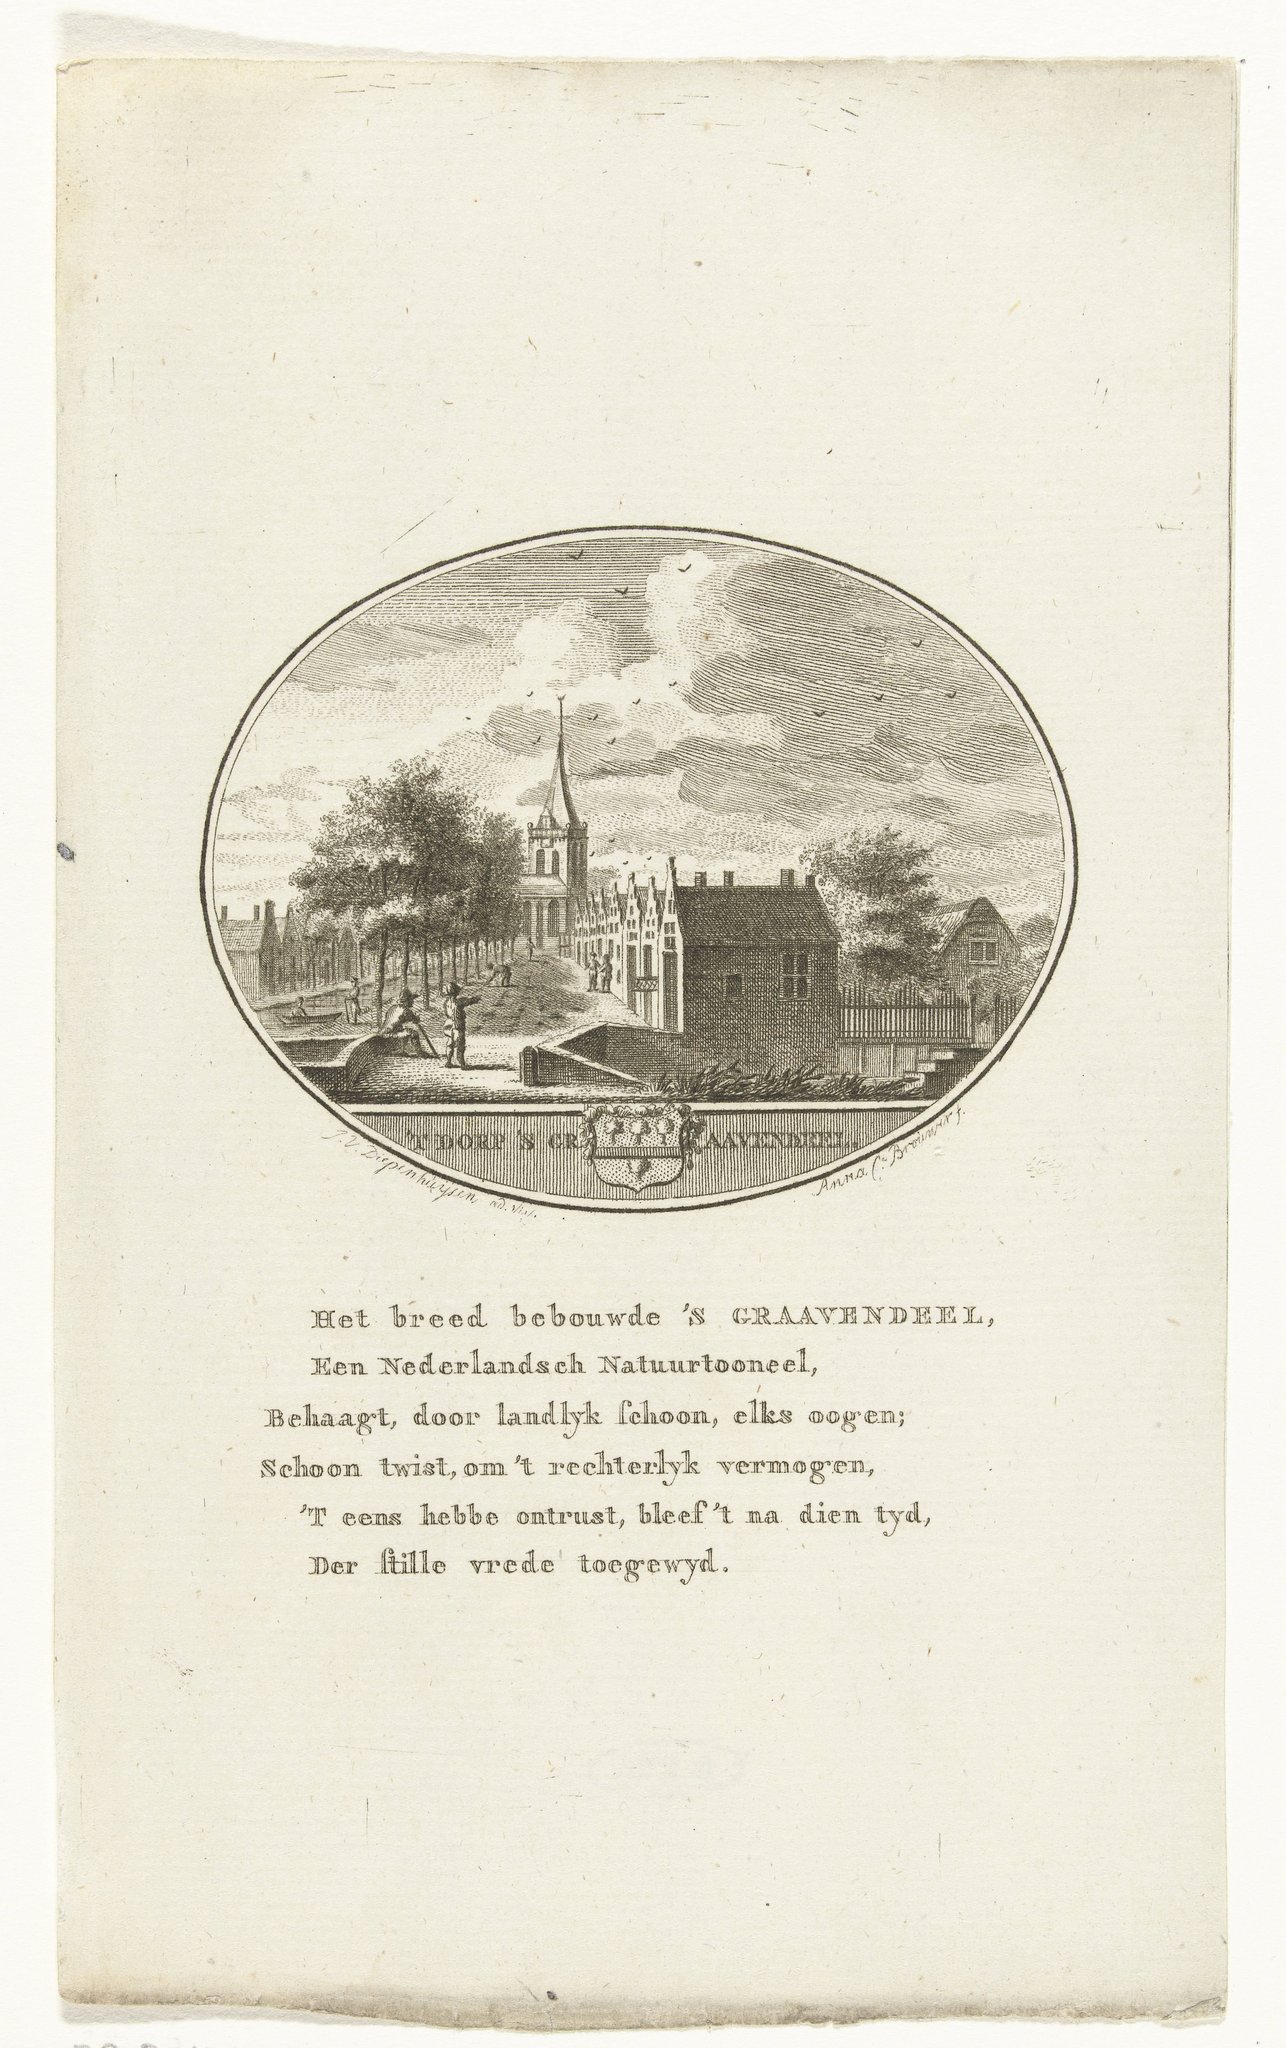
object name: print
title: Gezicht op het dorp 's-Gravendeel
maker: anna catharina brouwer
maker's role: print maker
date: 1791-1793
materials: paper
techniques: etching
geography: amsterdam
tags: city-view in general; 'veduta'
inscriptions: collector's mark: Lugt 2228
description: afkomstig uit: L. van Ollefen, De Nederlandsche stad- en dorp-beschrijver. Deel 1, Amsterdam: Hendrik Arend Banse, 1793.